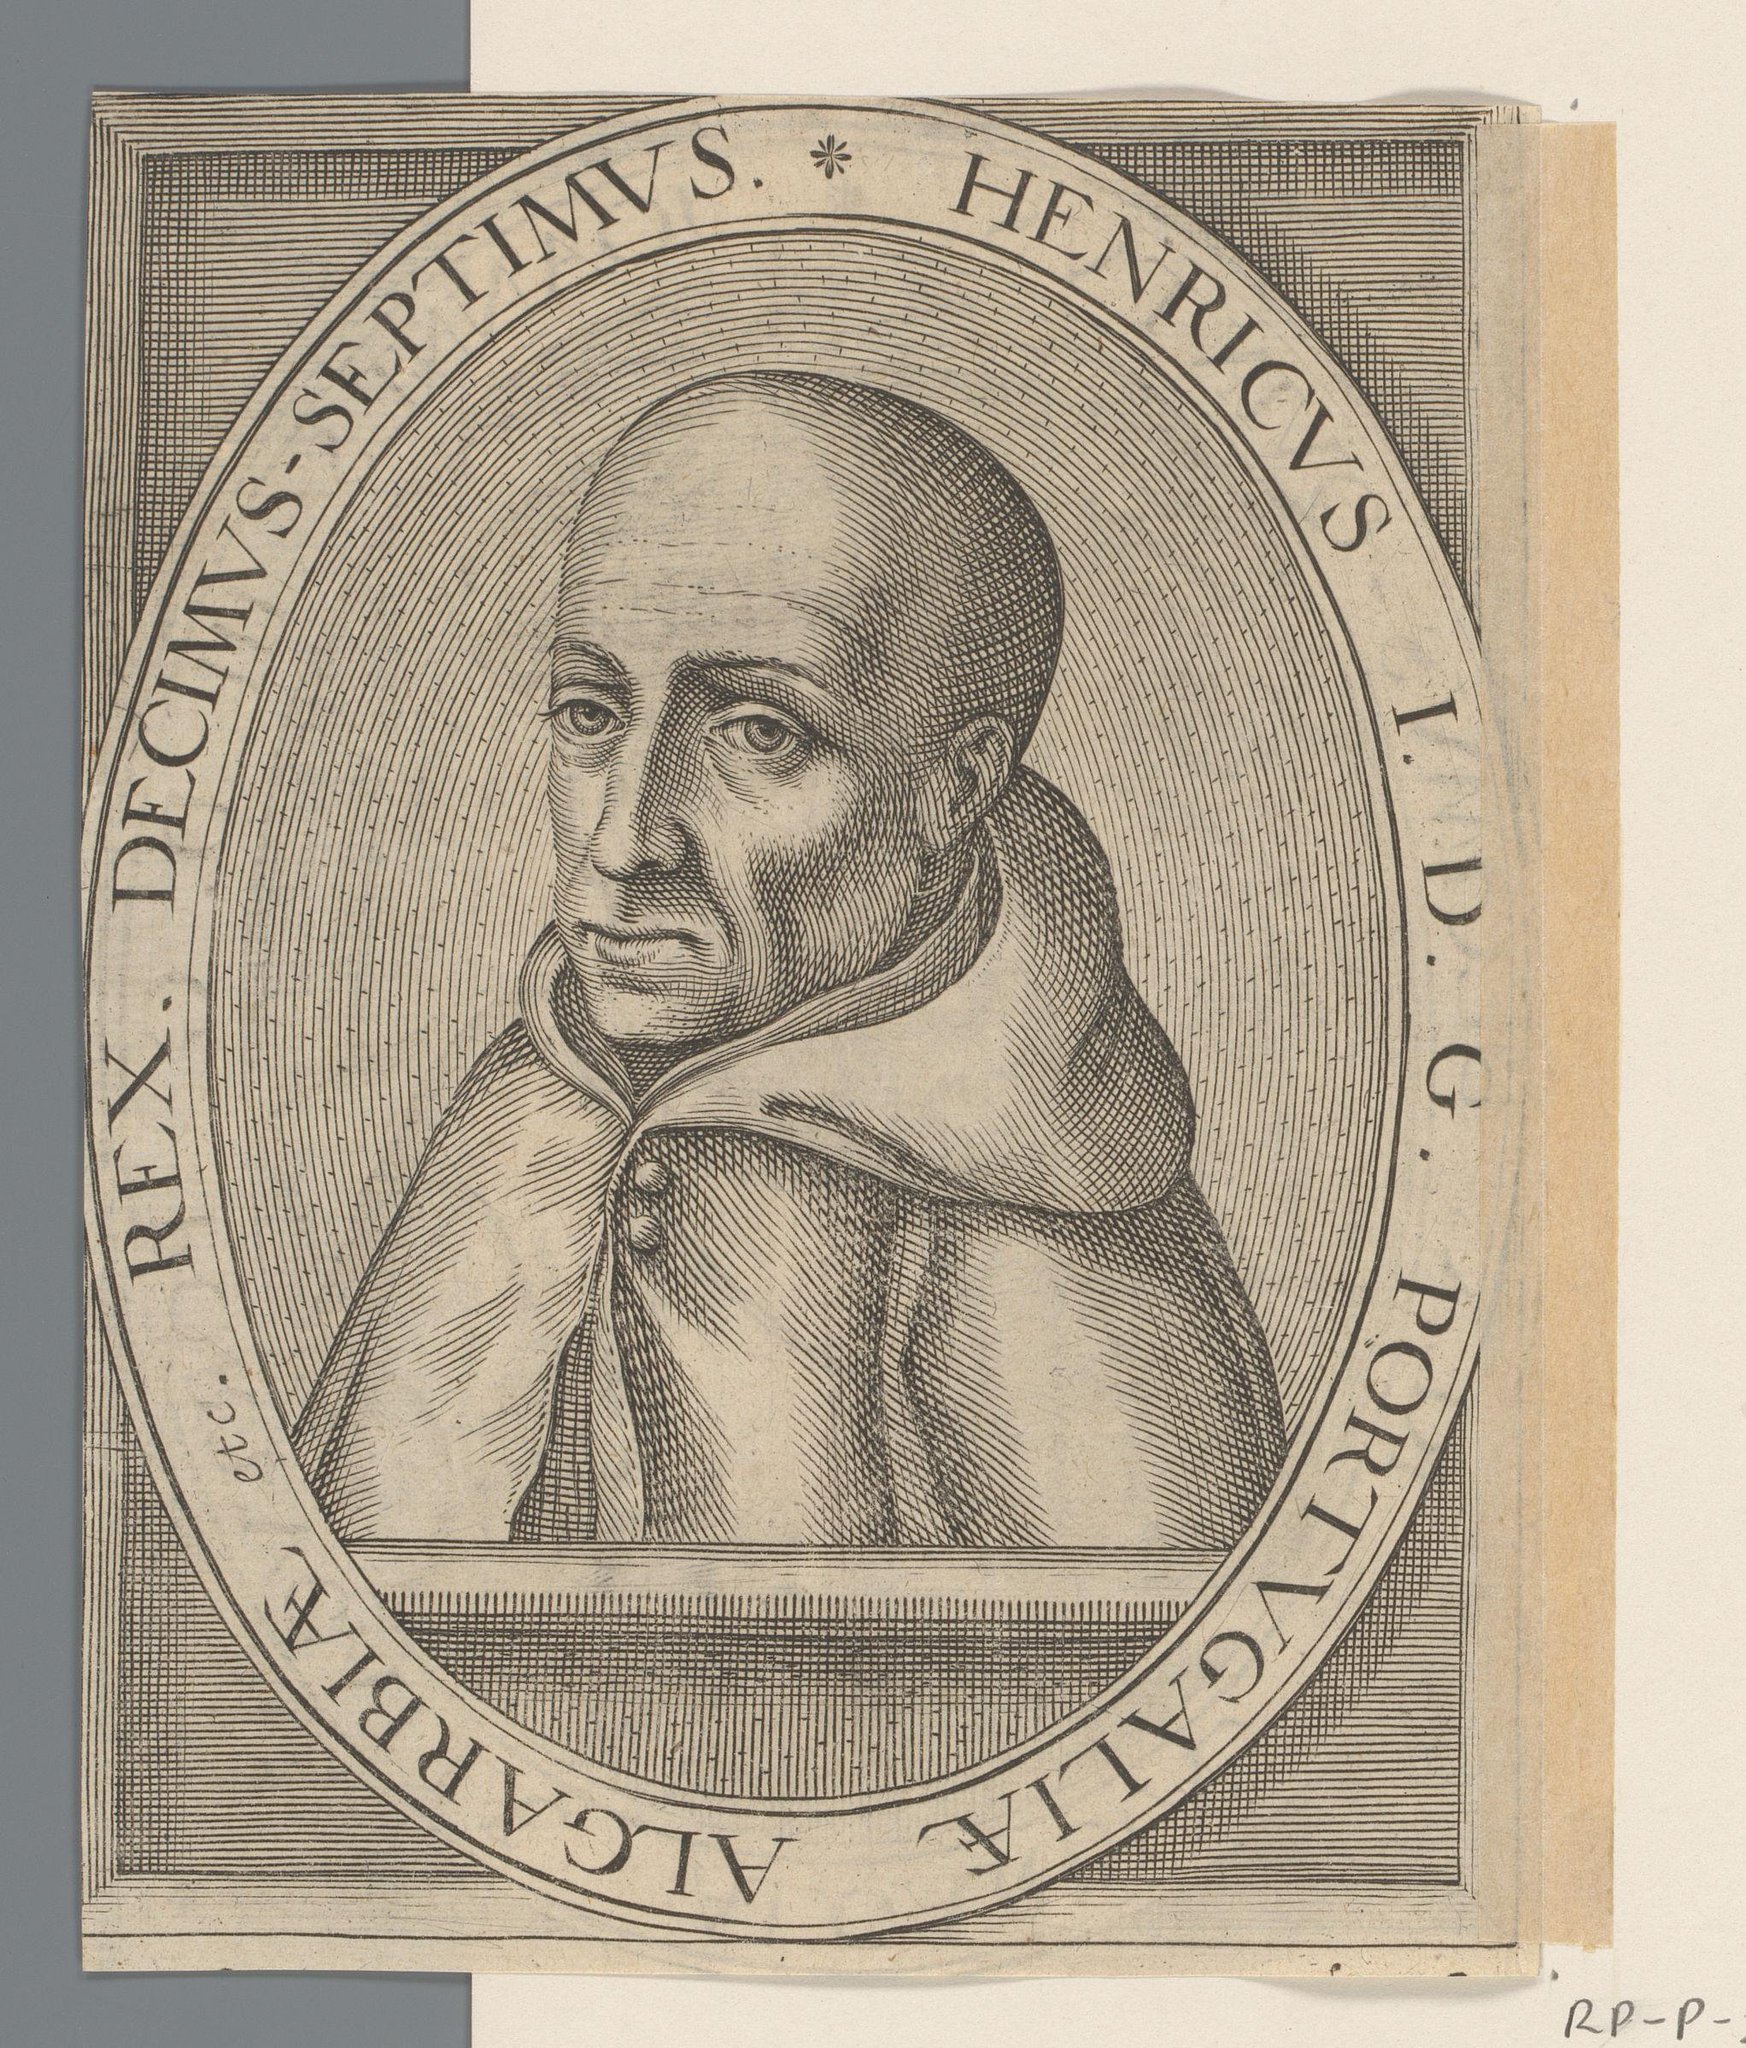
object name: book illustration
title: Portret van Hendrik I, koning van Portugal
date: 1621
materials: paper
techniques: engraving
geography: amsterdam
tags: historical persons, king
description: Prent uit: Avity, Pierre d'. Wereld spiegel: waer in vertoont word de beschrijvinge der rijken staten (...). Amsterdam: Jan Evertsz Cloppenburgh, 1621, p. 143.